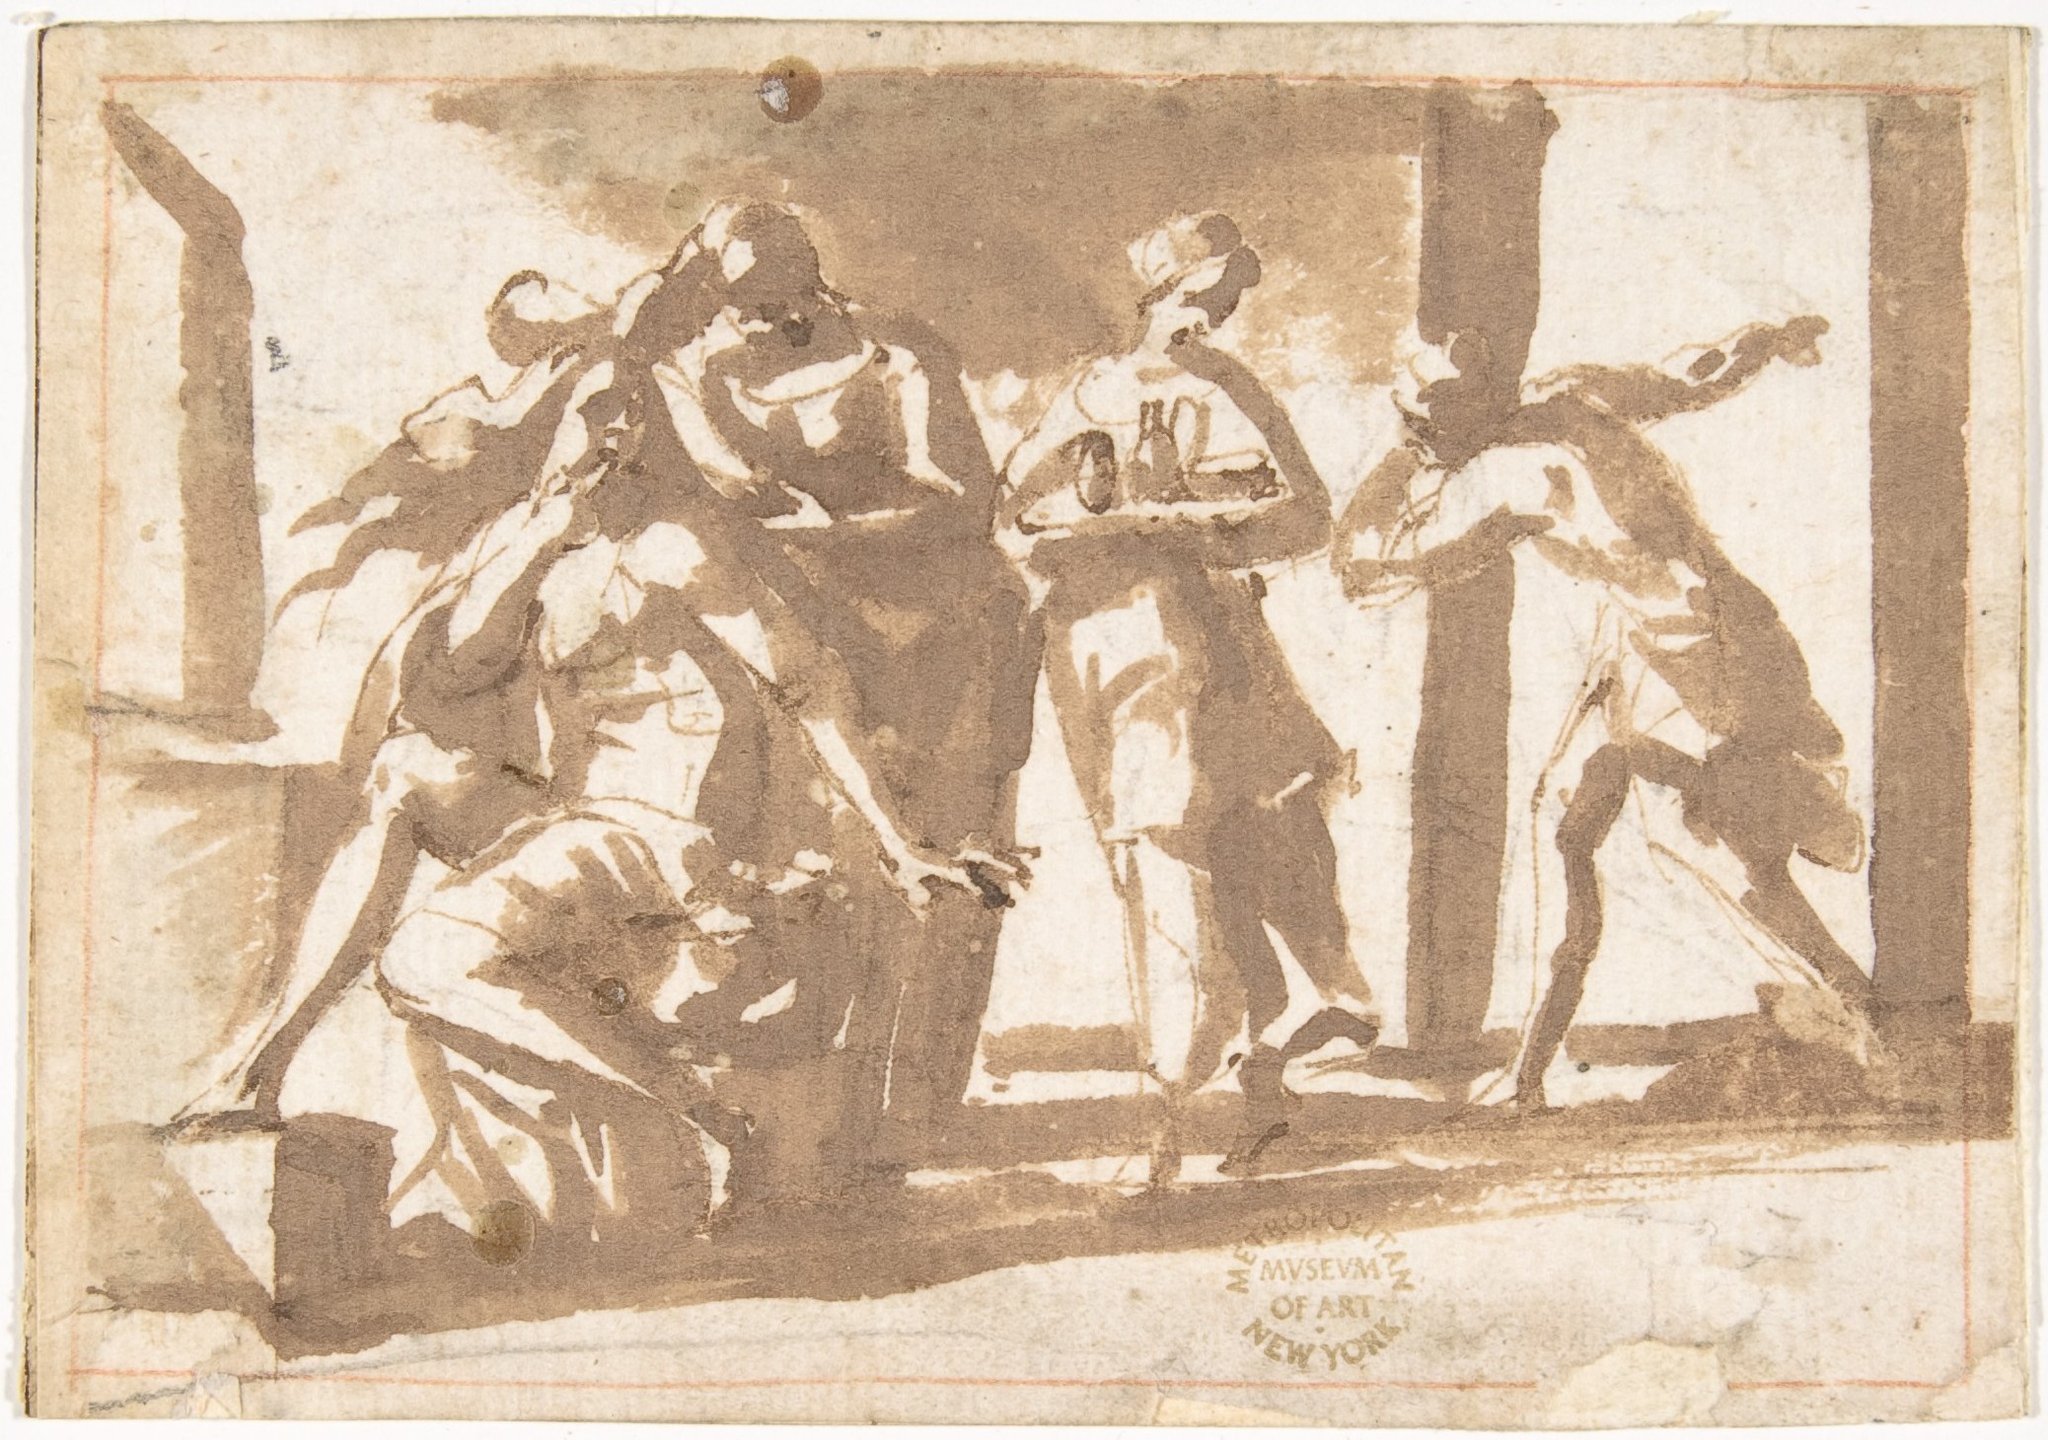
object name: drawing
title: The Departure of Aeneas Announced to Dido?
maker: francesco allegrini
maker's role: artist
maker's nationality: italian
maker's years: 1615-1679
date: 1624-1663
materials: chalk, ink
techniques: brush, pen, wash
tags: women,aeneas